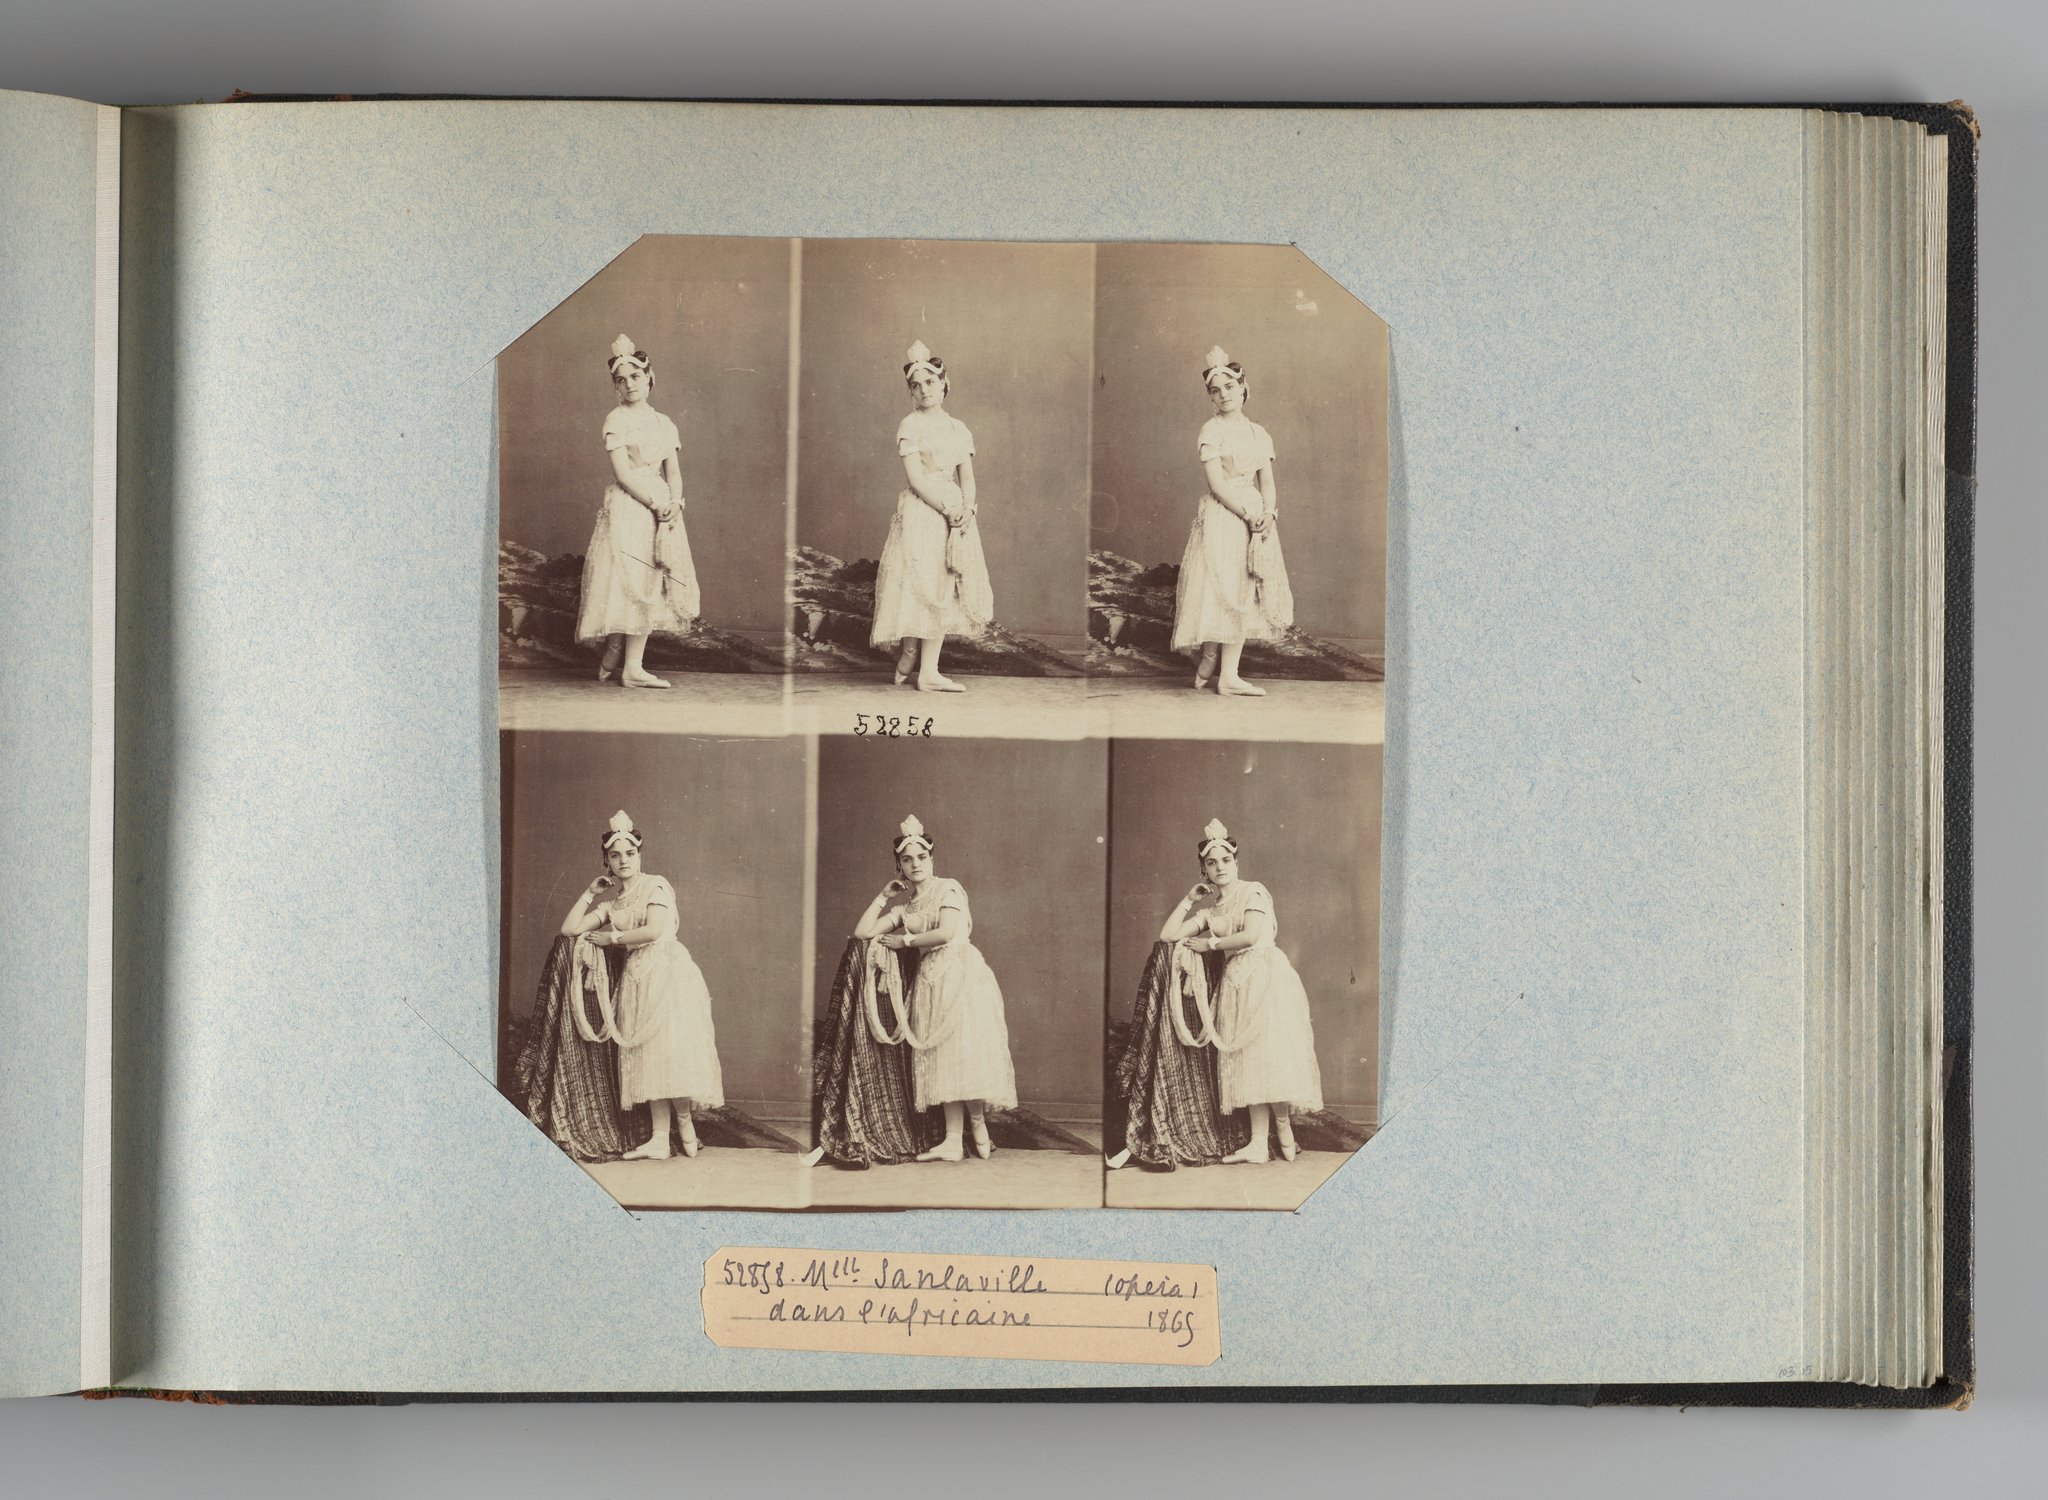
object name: photograph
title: Mlle Sanlaville dans l'Africaine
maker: andré-adolphe-eugène disdéri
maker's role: artist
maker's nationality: french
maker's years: 1819-1889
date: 1865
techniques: albumen silver print, glass negative